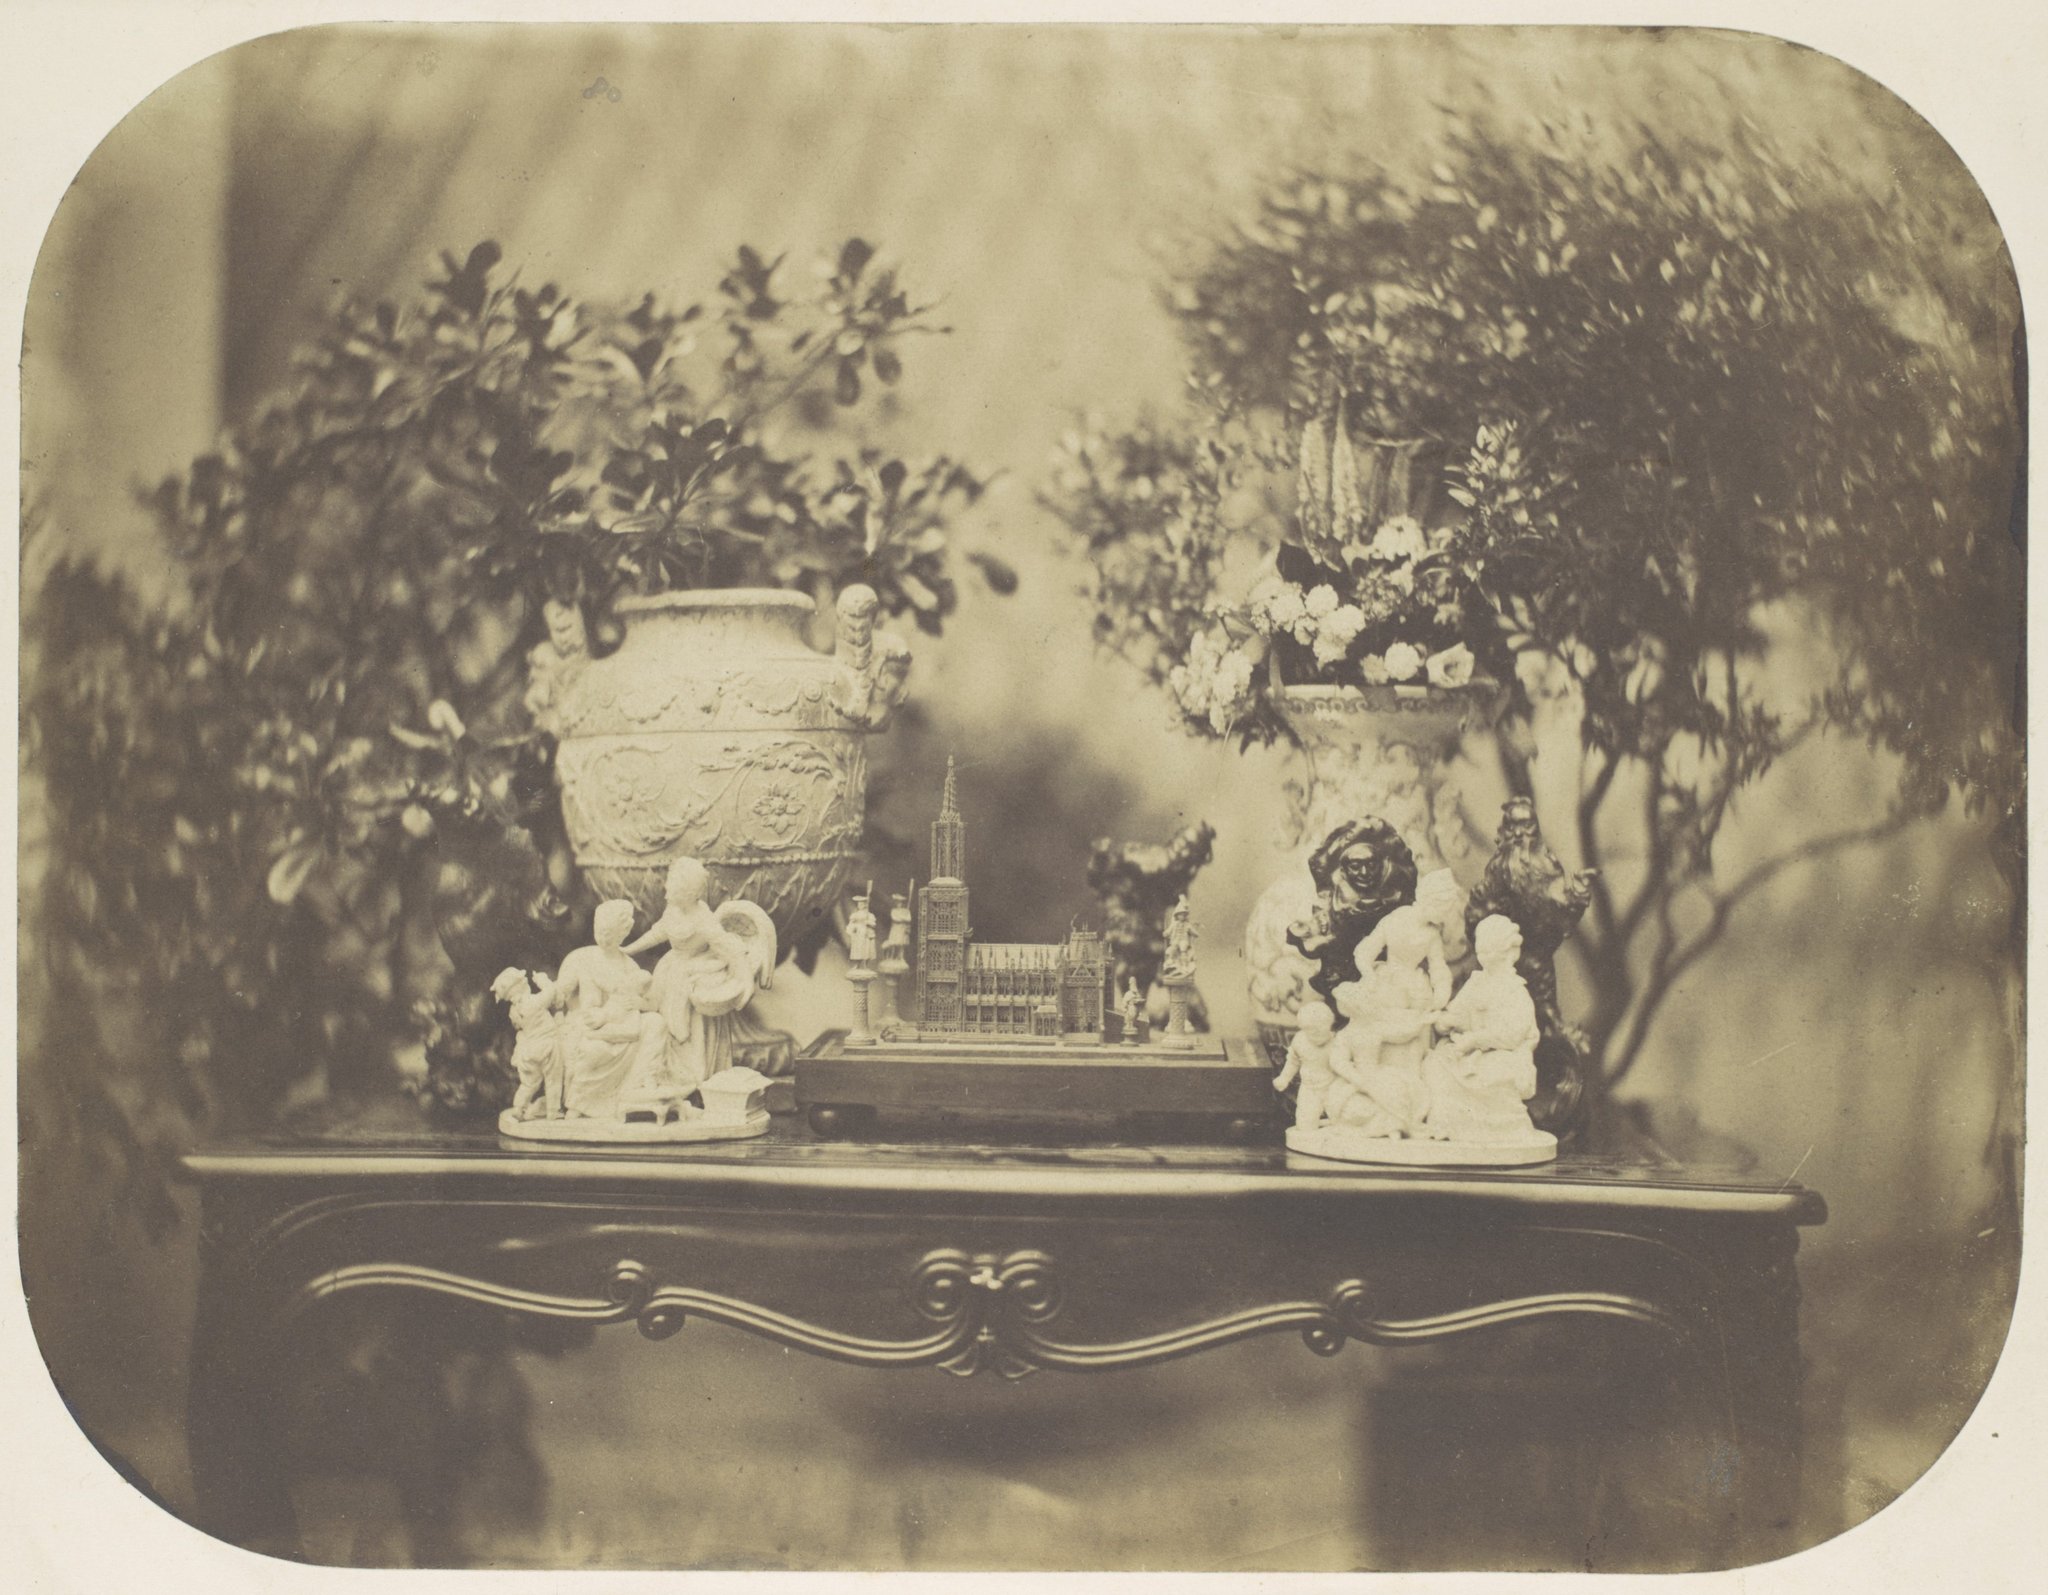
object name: photograph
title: [Table Top Still Life with Model Cathedral and Small Sculptures]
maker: louis-rémy robert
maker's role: artist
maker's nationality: french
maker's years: 1810-1882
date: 1856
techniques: glass negative, salted paper print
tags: plants,still life,vases